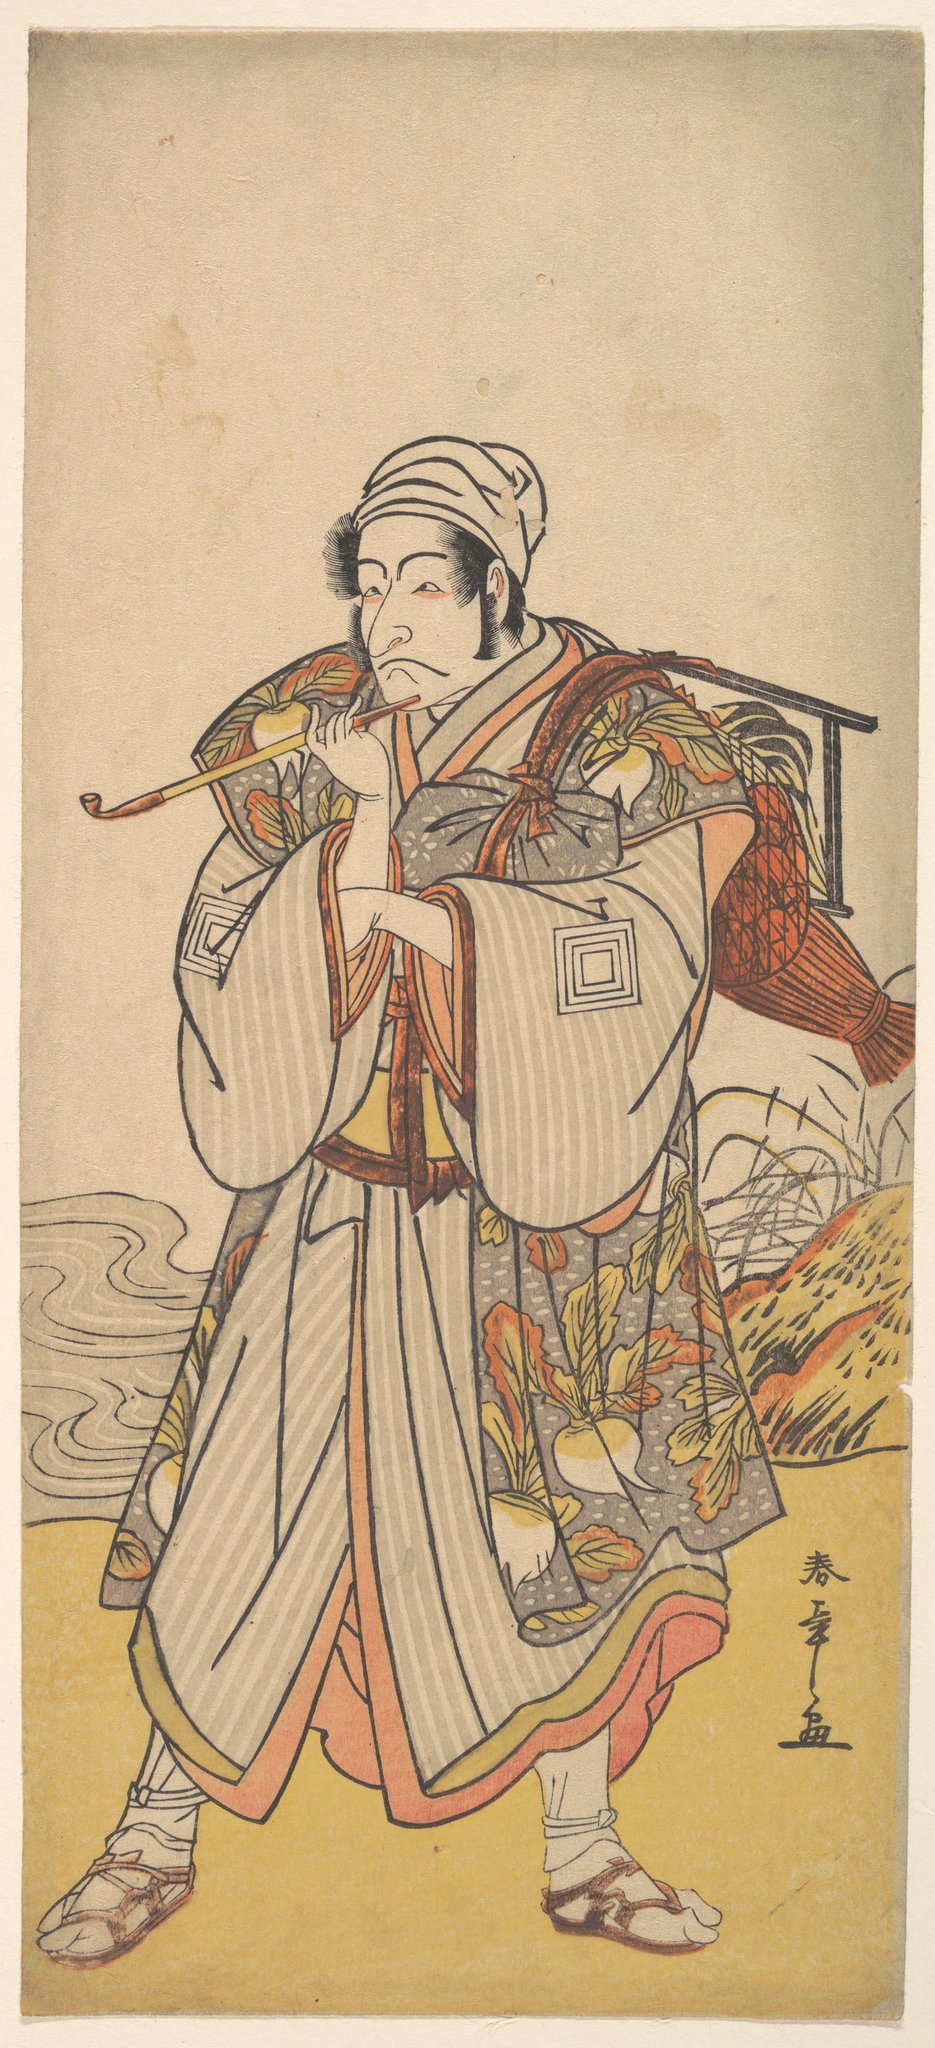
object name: woodblock print nishiki e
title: The Actor Danjuro III as an Itinerant Peddler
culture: japanese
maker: katsukawa shunshō 勝川春章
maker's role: artist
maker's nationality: japanese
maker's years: 1726-1792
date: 1726-1792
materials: ink, paper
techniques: nishiki e, woodblock print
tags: men,actors